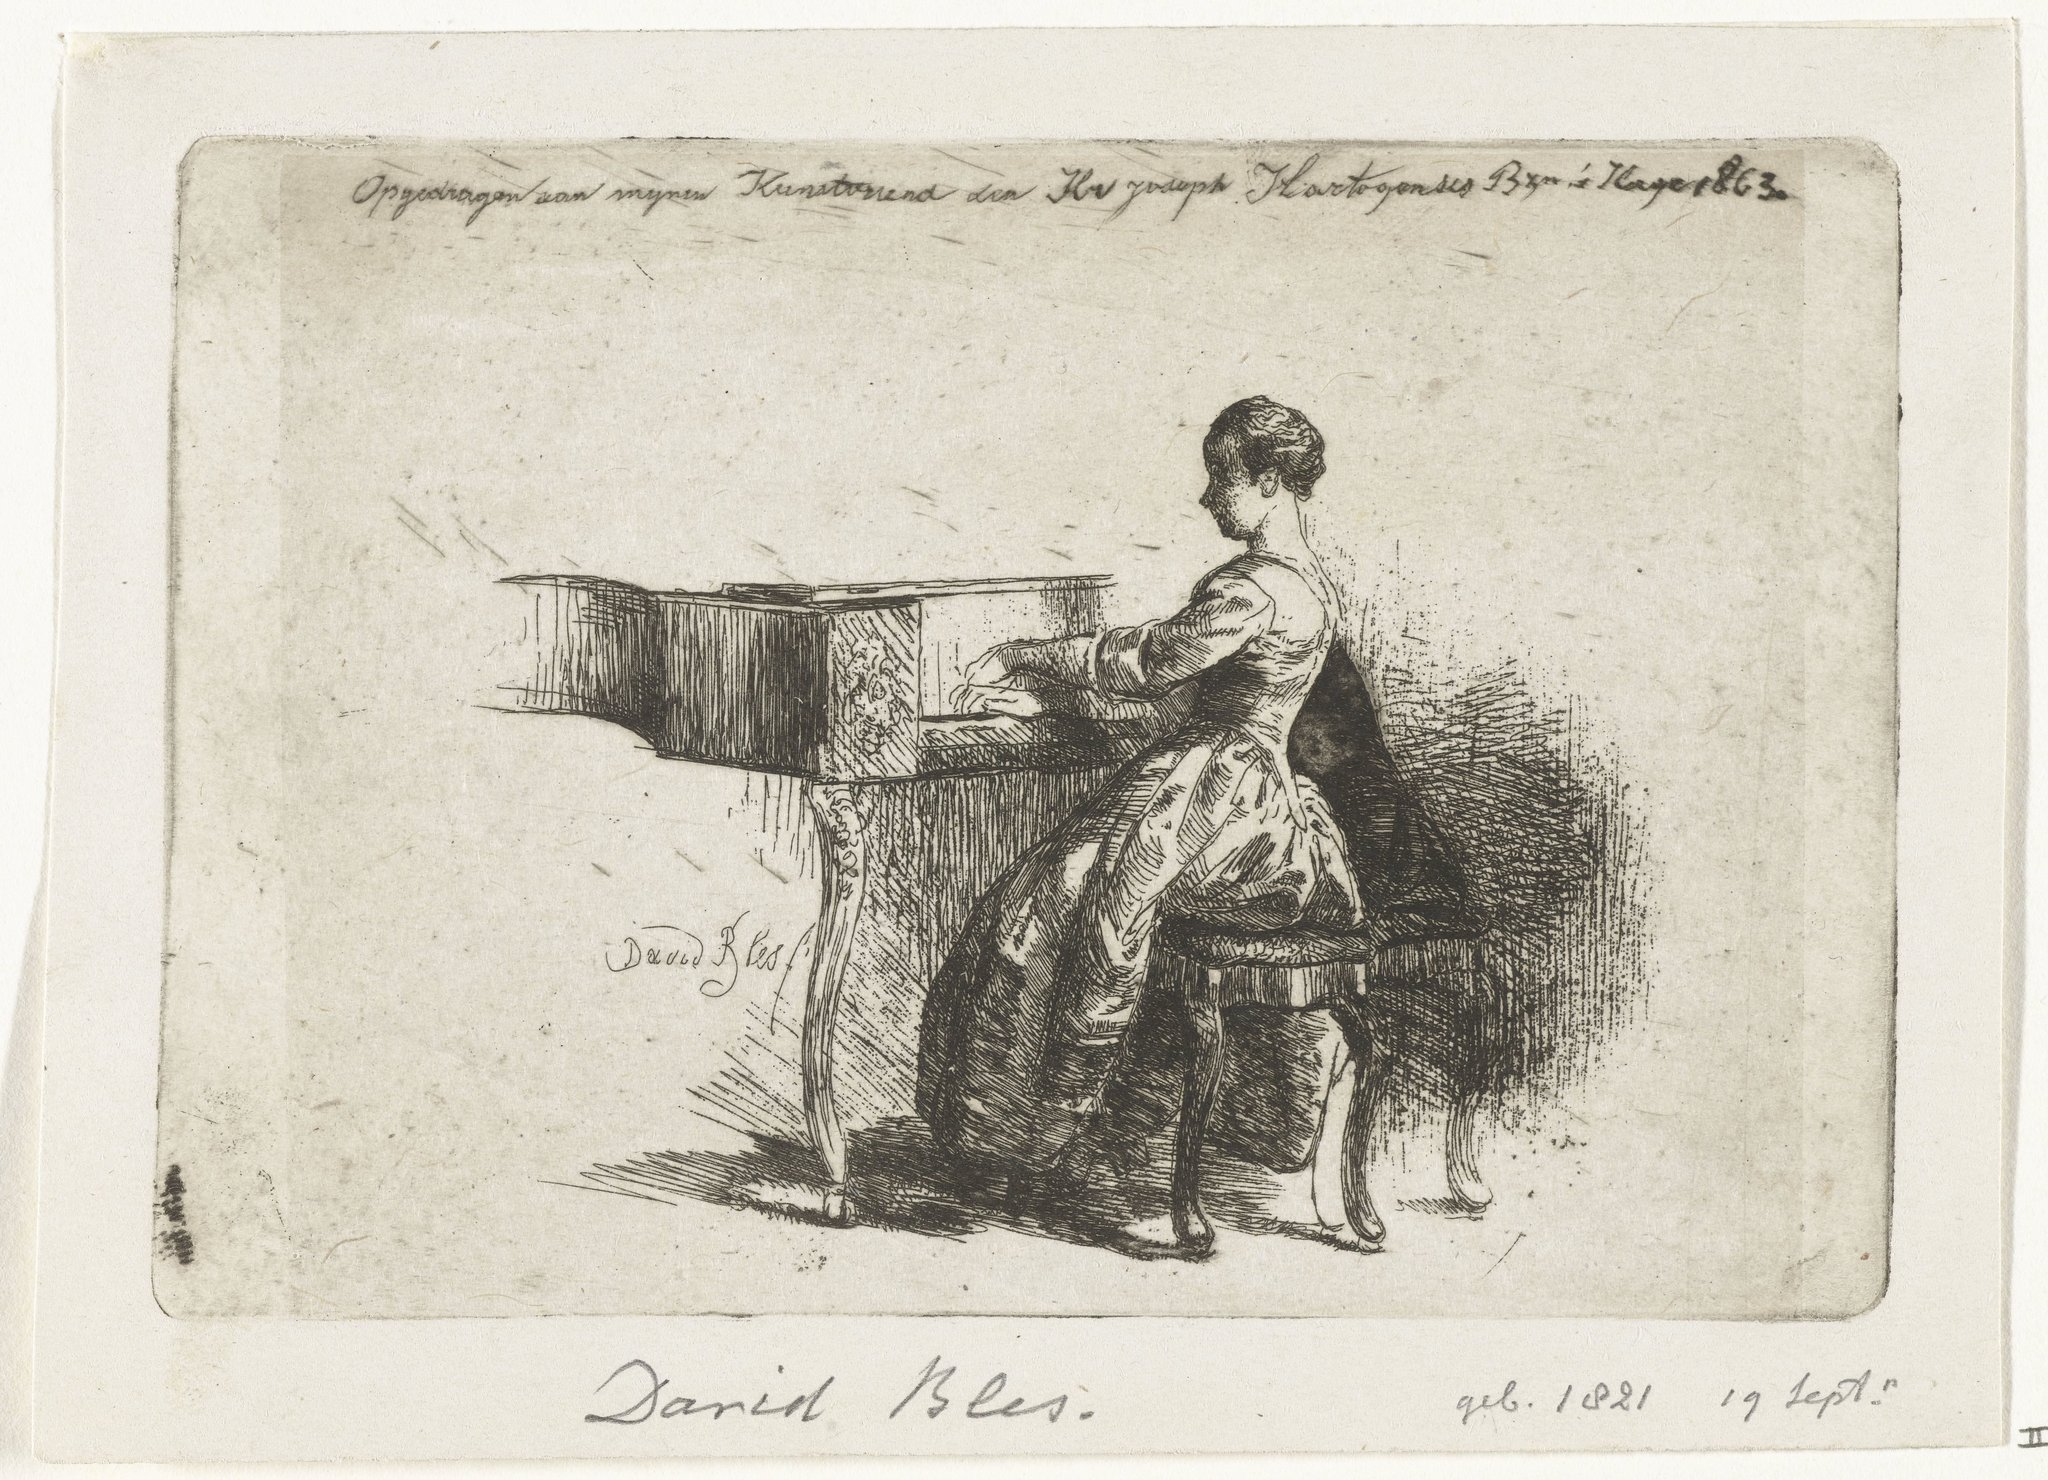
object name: print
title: Meisje aan de piano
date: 1863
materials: paper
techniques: etching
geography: the hague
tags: one person playing keyboard instrument, clavichord, harpsichord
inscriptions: collector's mark: Lugt 2228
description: Een meisje zit op een pianokruk en speelt op een sierlijke fortepiano of klavecimbel.